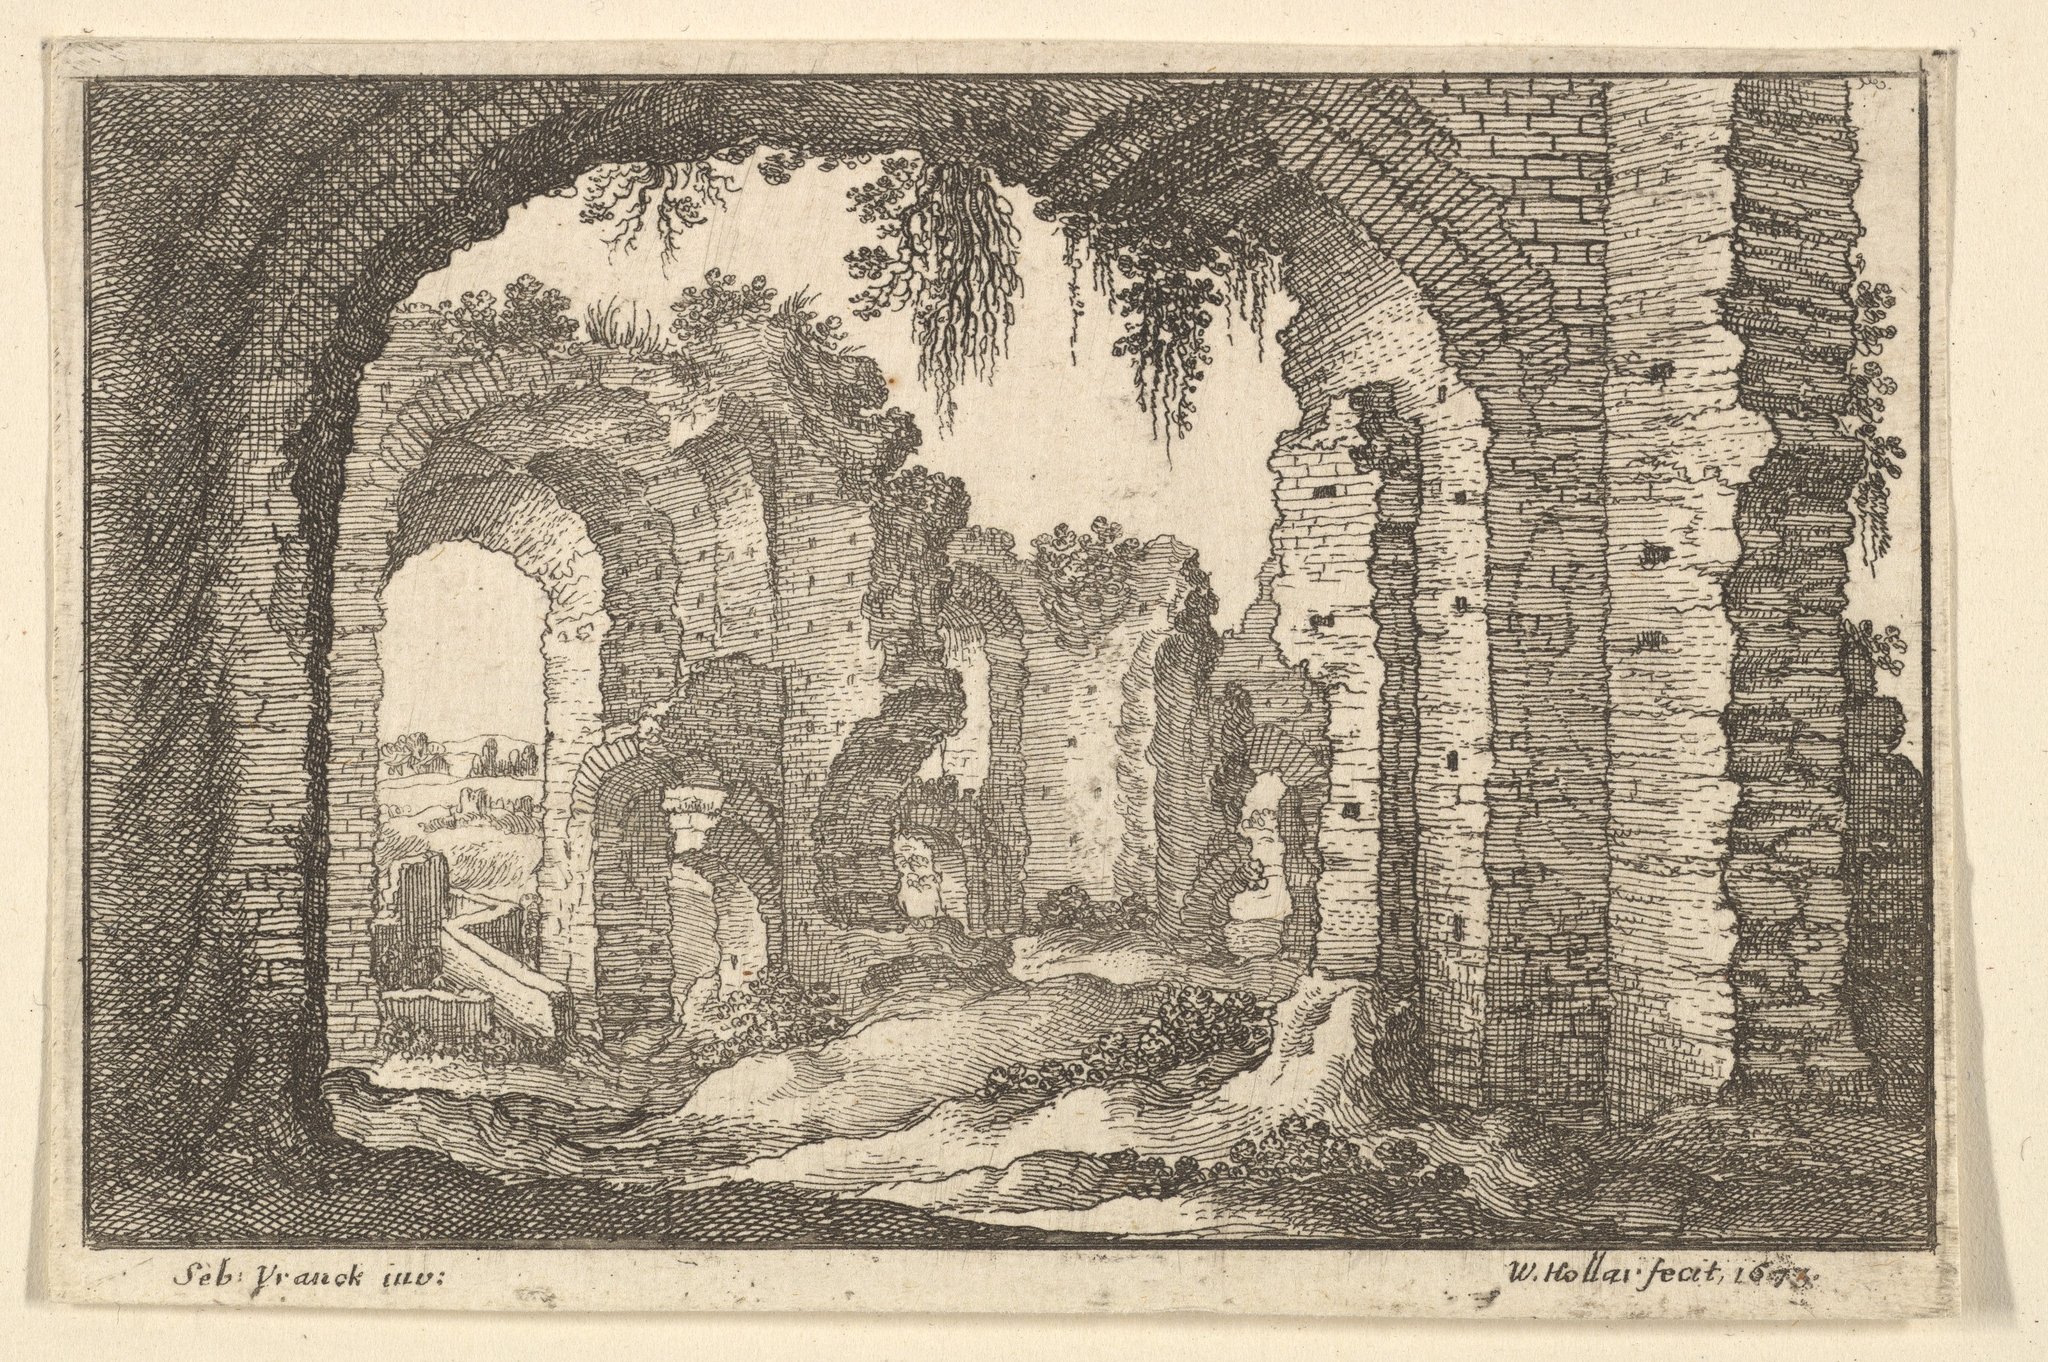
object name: print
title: Roman Ruins, from "Roman Ruins"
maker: wenceslaus hollar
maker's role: artist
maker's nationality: bohemian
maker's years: 1607-1677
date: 1673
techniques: etching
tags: ruins,plants